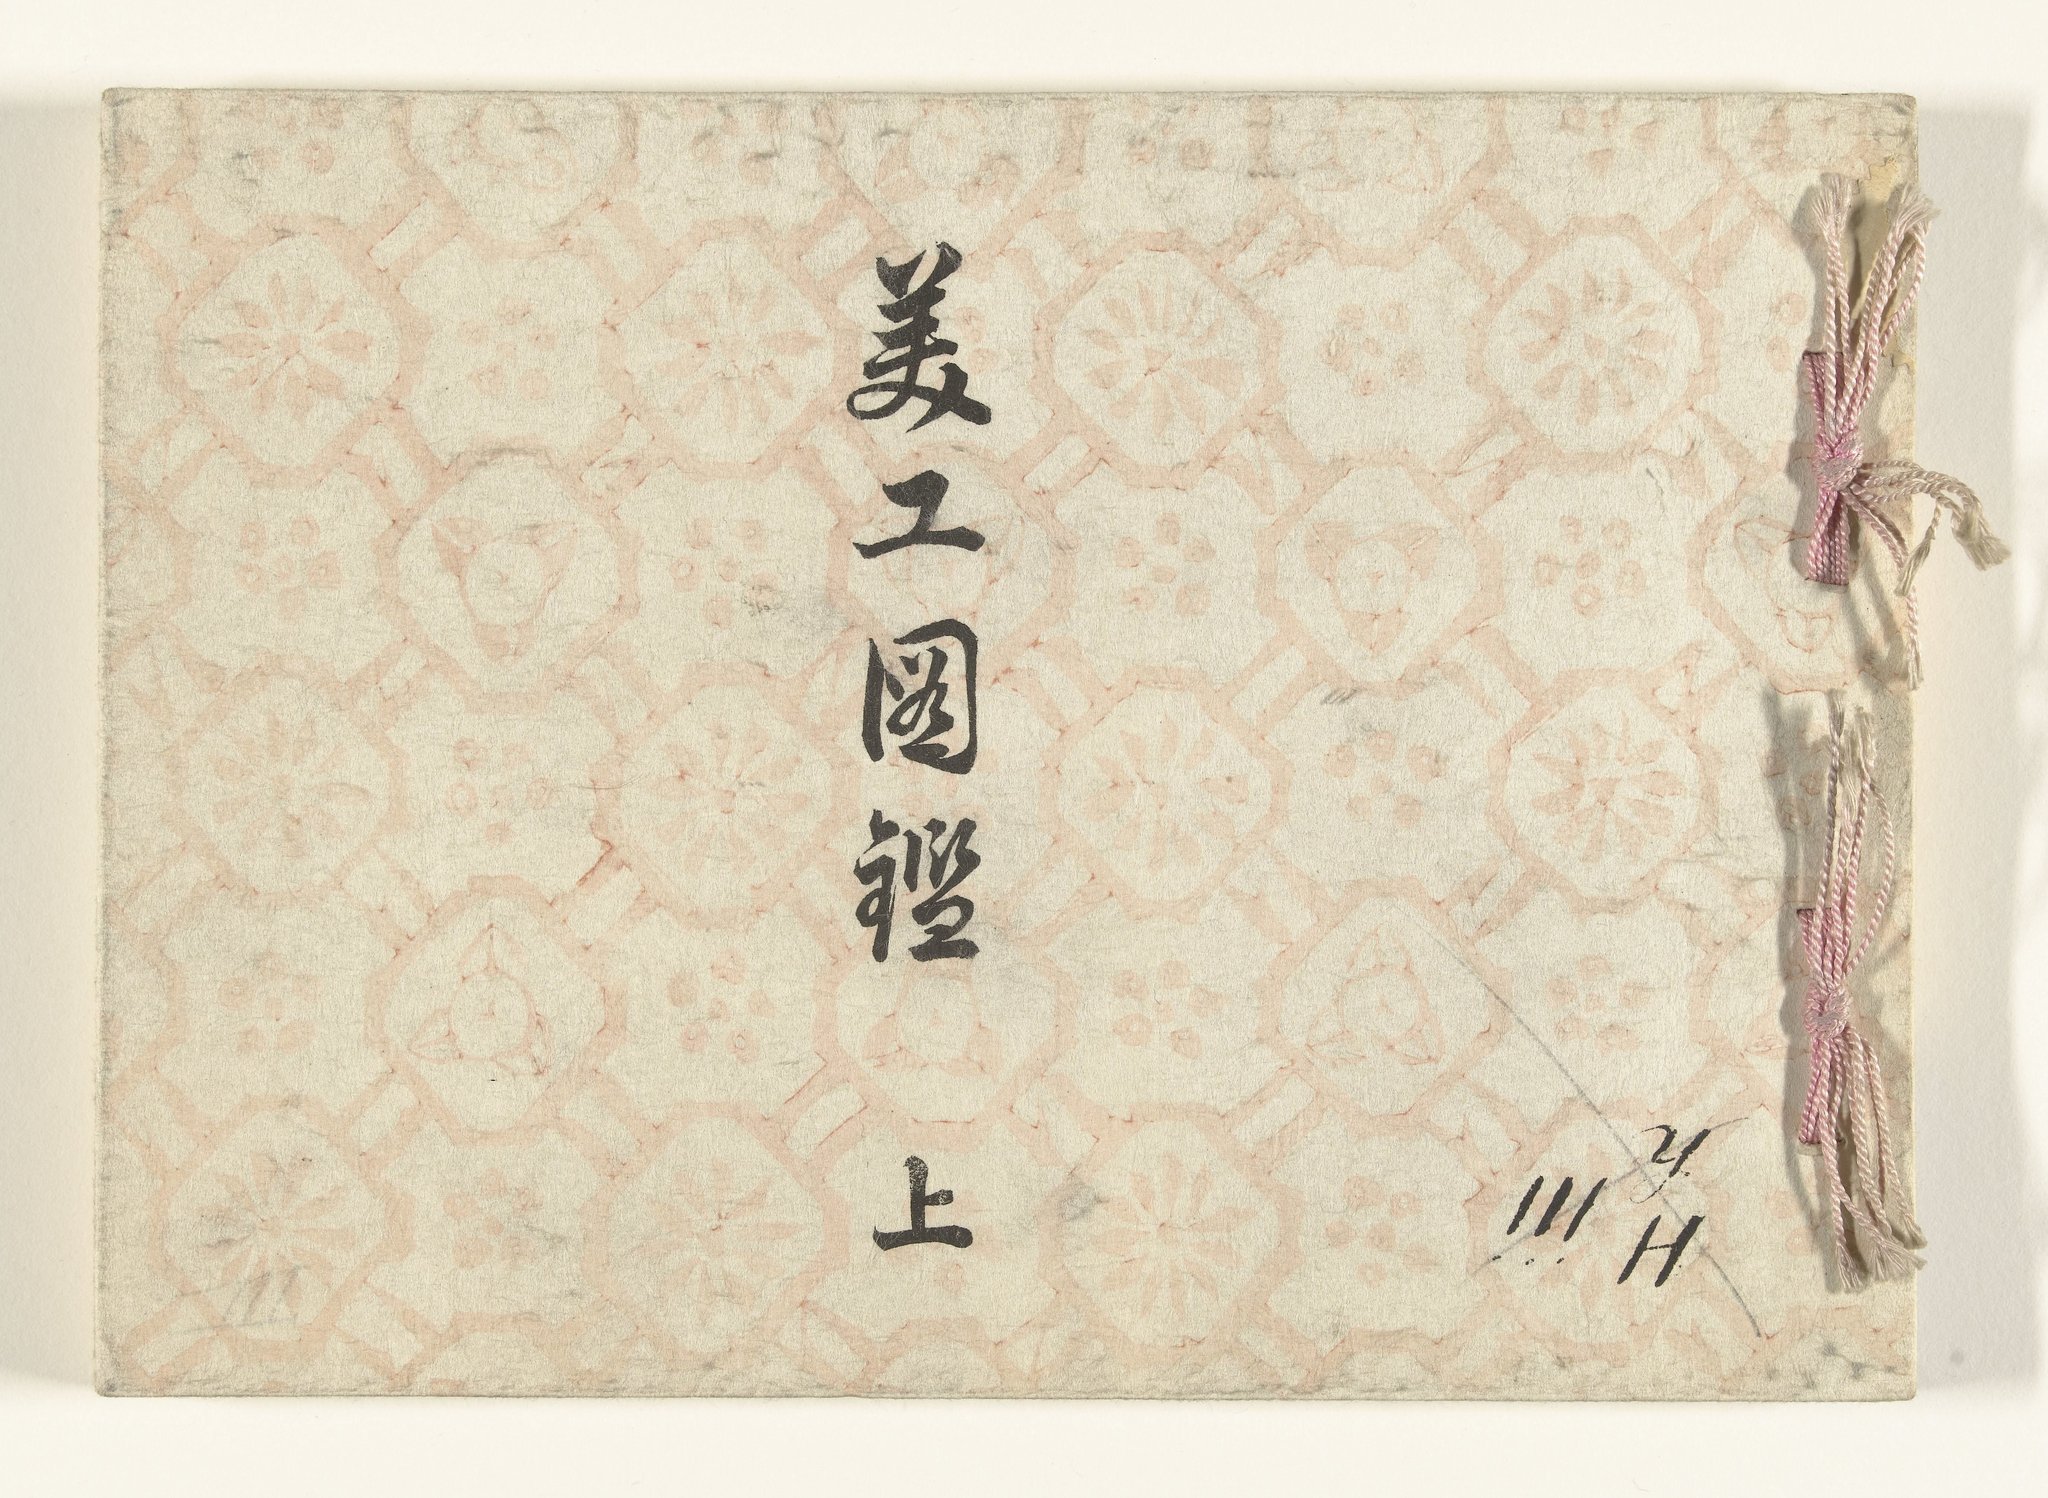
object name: book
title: Afbeeldingen van Schone ambachten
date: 1894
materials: paper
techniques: woodcut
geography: japan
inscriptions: collector's mark: ‘Rijksschool voor kunstnijverheid’ Lugt 3937